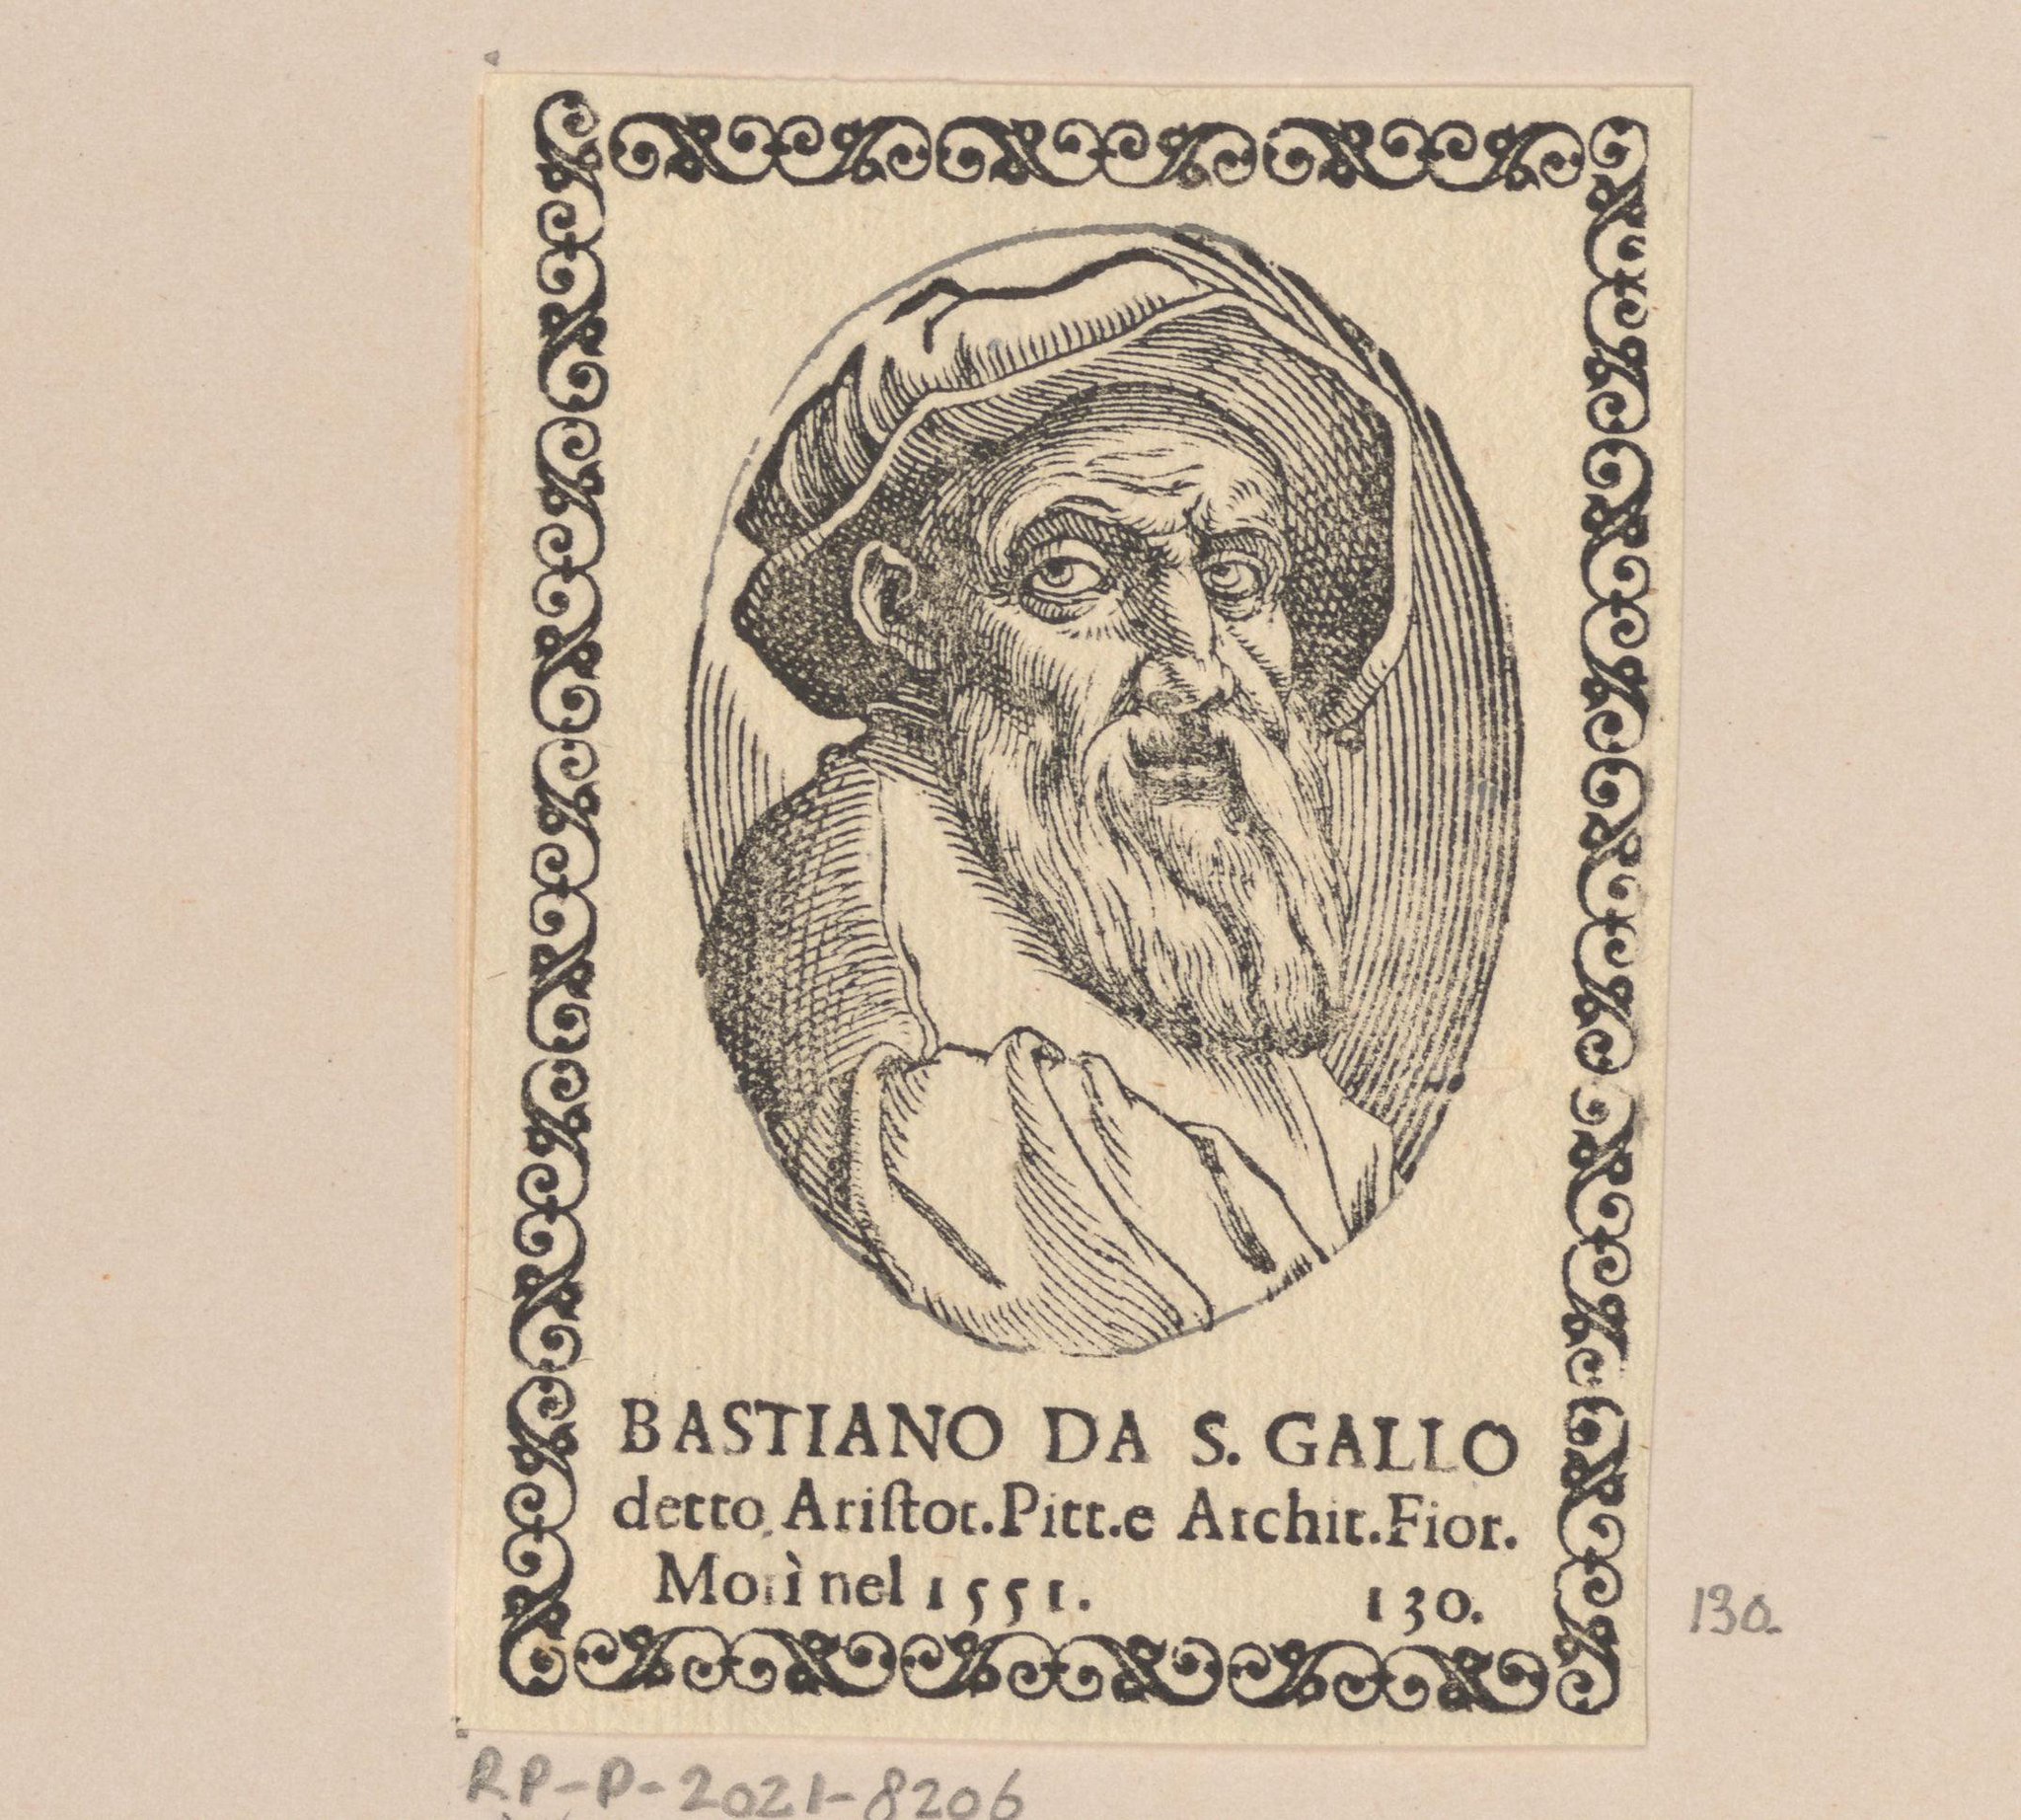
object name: print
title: Portret van Bastiano da Sangallo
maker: cristoforo coriolano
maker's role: print maker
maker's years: 1540-1610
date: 1568-1650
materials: paper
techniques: letterpress printing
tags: sculptor, historical persons, portrait, self-portrait of architect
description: Prent komt uit een editie van Vasari's 'Vite'. Prent met een andere omlijsting gebruikt in: Vasari, Giorgio. Le vite de' piu eccellenti pittori scultori, e architettori. Florence: Filippo Giunta, 1568. En mogelijk in de editie uit 1647.